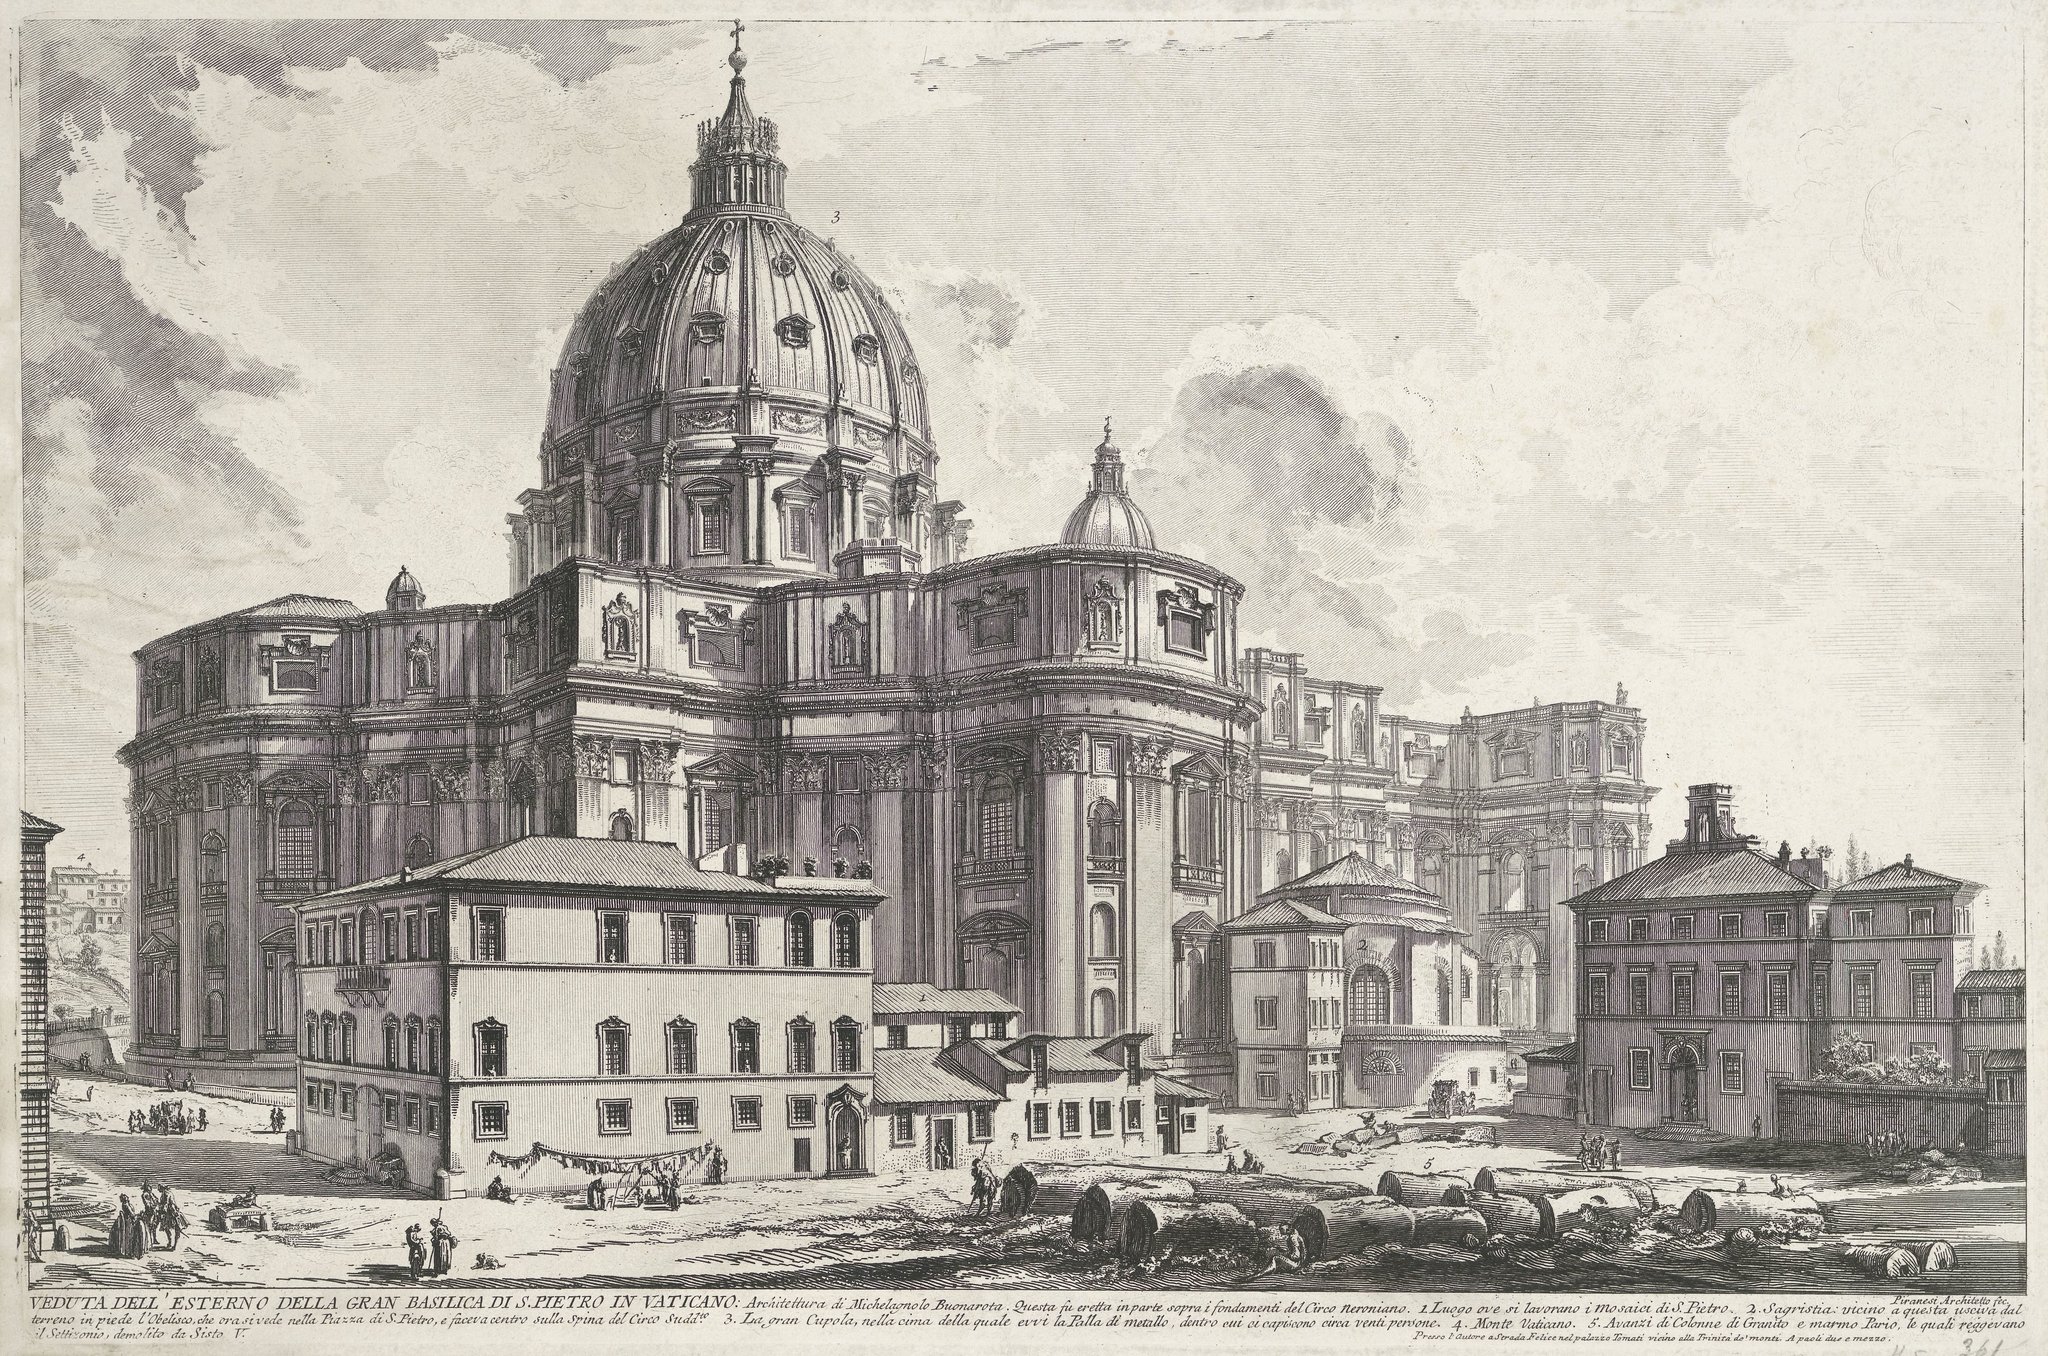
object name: print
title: Vedute di Roma disegnate ed incise da Giambattista Piranesi architetto Ve(nez)iano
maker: giovanni battista piranesi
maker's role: designer, draughtsman, print maker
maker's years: 1720-1778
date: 1748-1778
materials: paper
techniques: etching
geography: rome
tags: church (exterior), roman catholic church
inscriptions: collector's mark: Lugt 2228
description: Deze prent maakt deel uit van de serie 'Vedute di Roma'. Piranesi werkte aan deze 135 platen tellende serie tussen 1748 en zijn dood in 1778. Francesco Piranesi voegde later nog twee prenten toe aan de reeks van zijn vader.